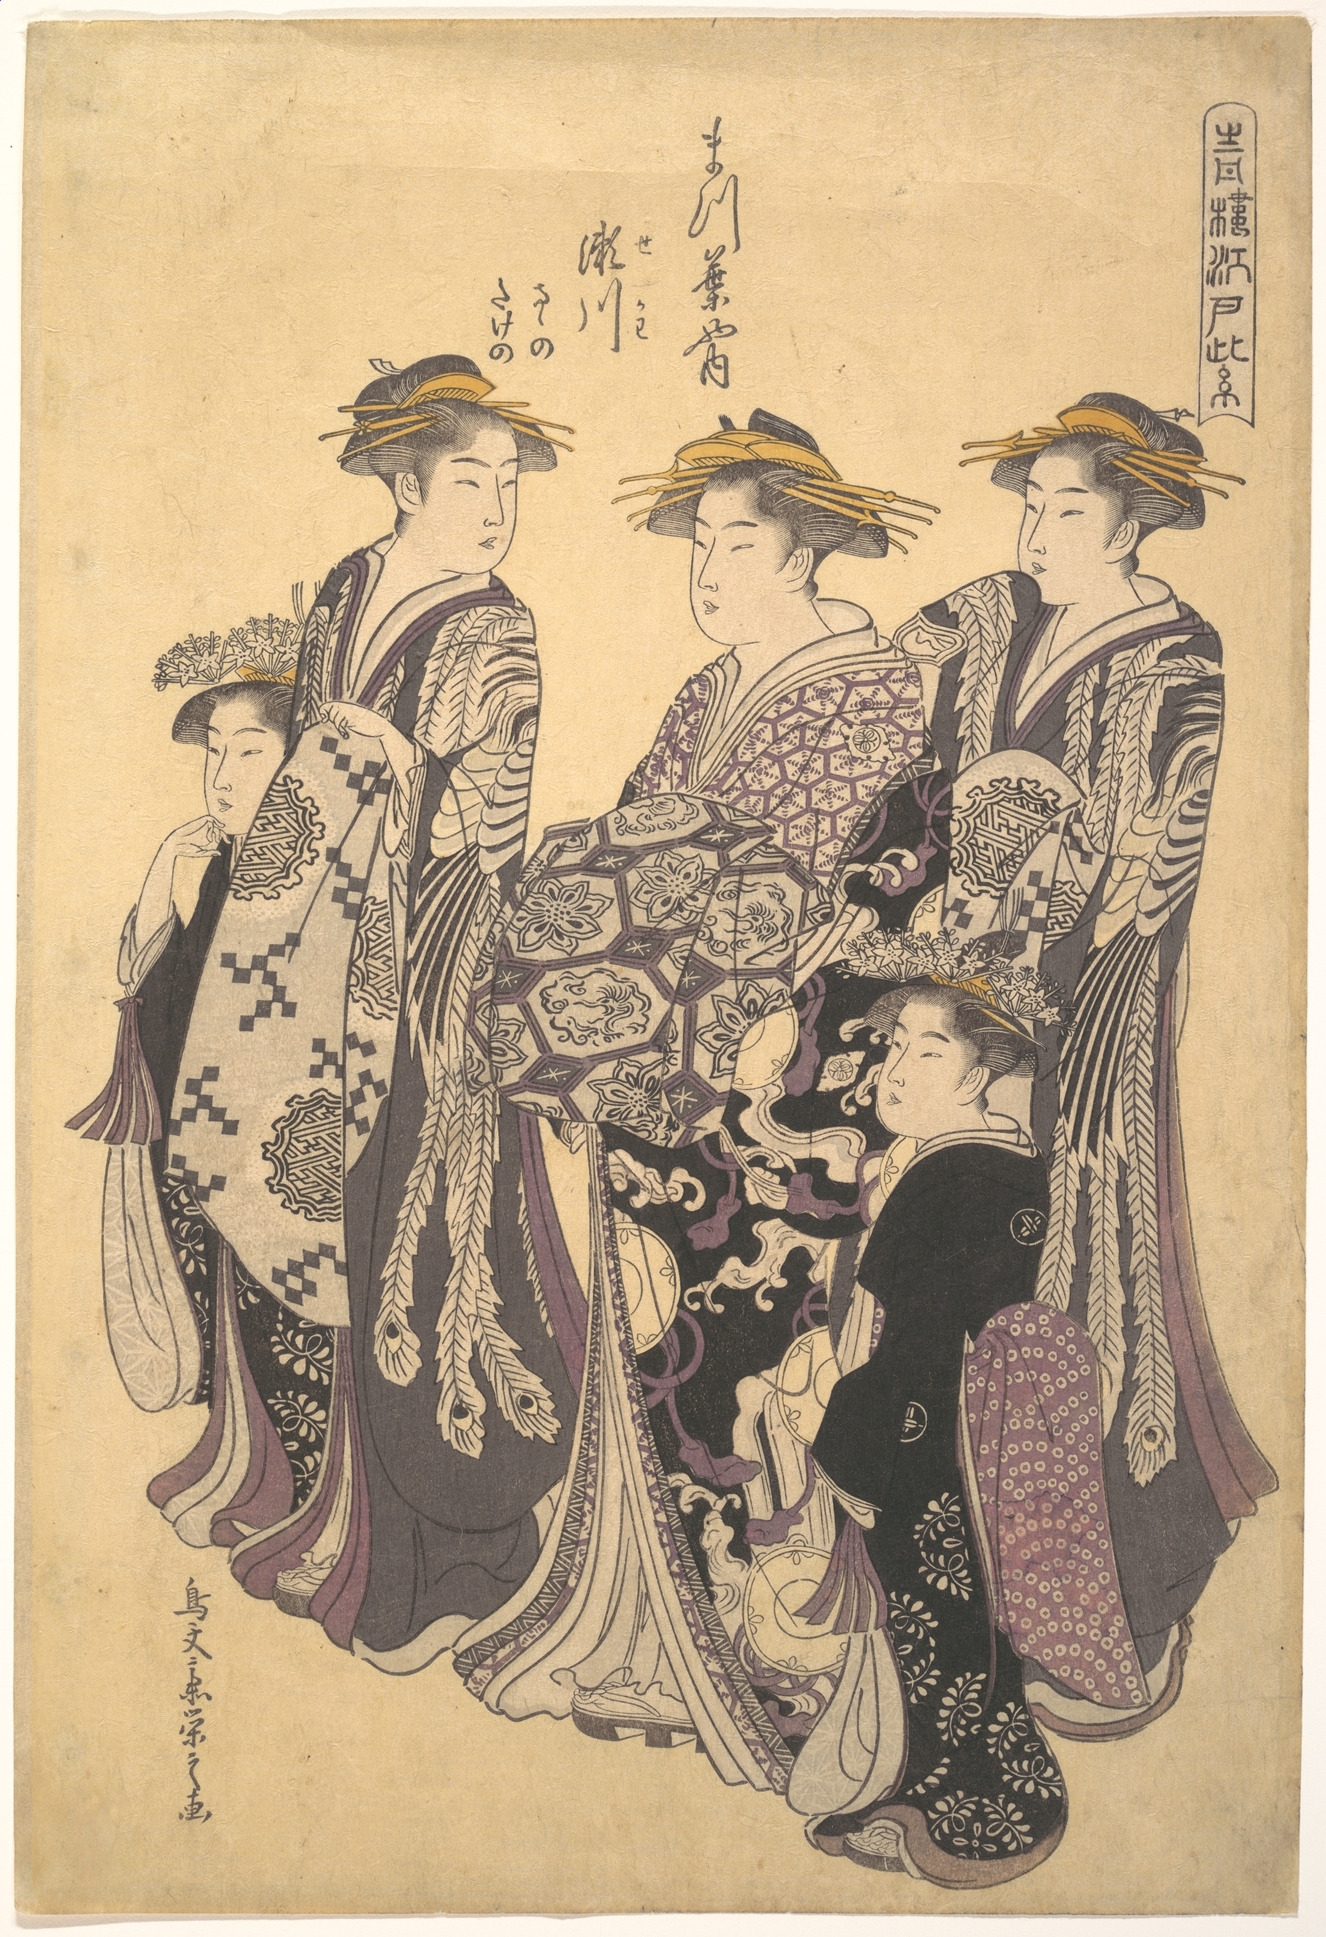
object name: print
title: Courtesan District of Edo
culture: japanese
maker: chōbunsai eishi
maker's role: artist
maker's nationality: japanese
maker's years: 1756-1829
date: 1756-1829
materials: ink, paper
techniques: woodblock print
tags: women